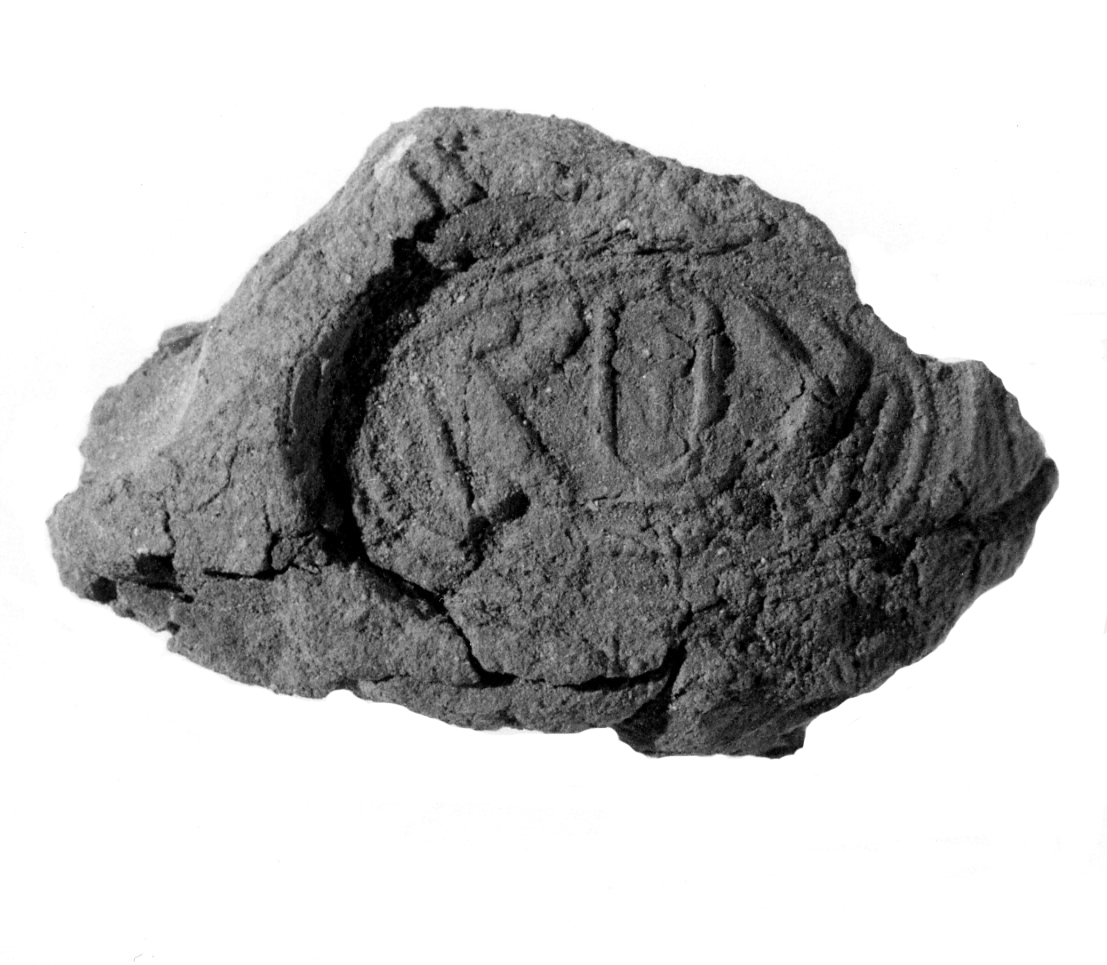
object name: sealing, amenhotep iii, nebmaatre. winged cobra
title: Document Sealing with the Throne Name of Amenhotep III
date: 1390-1352 BCE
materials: mud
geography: egypt